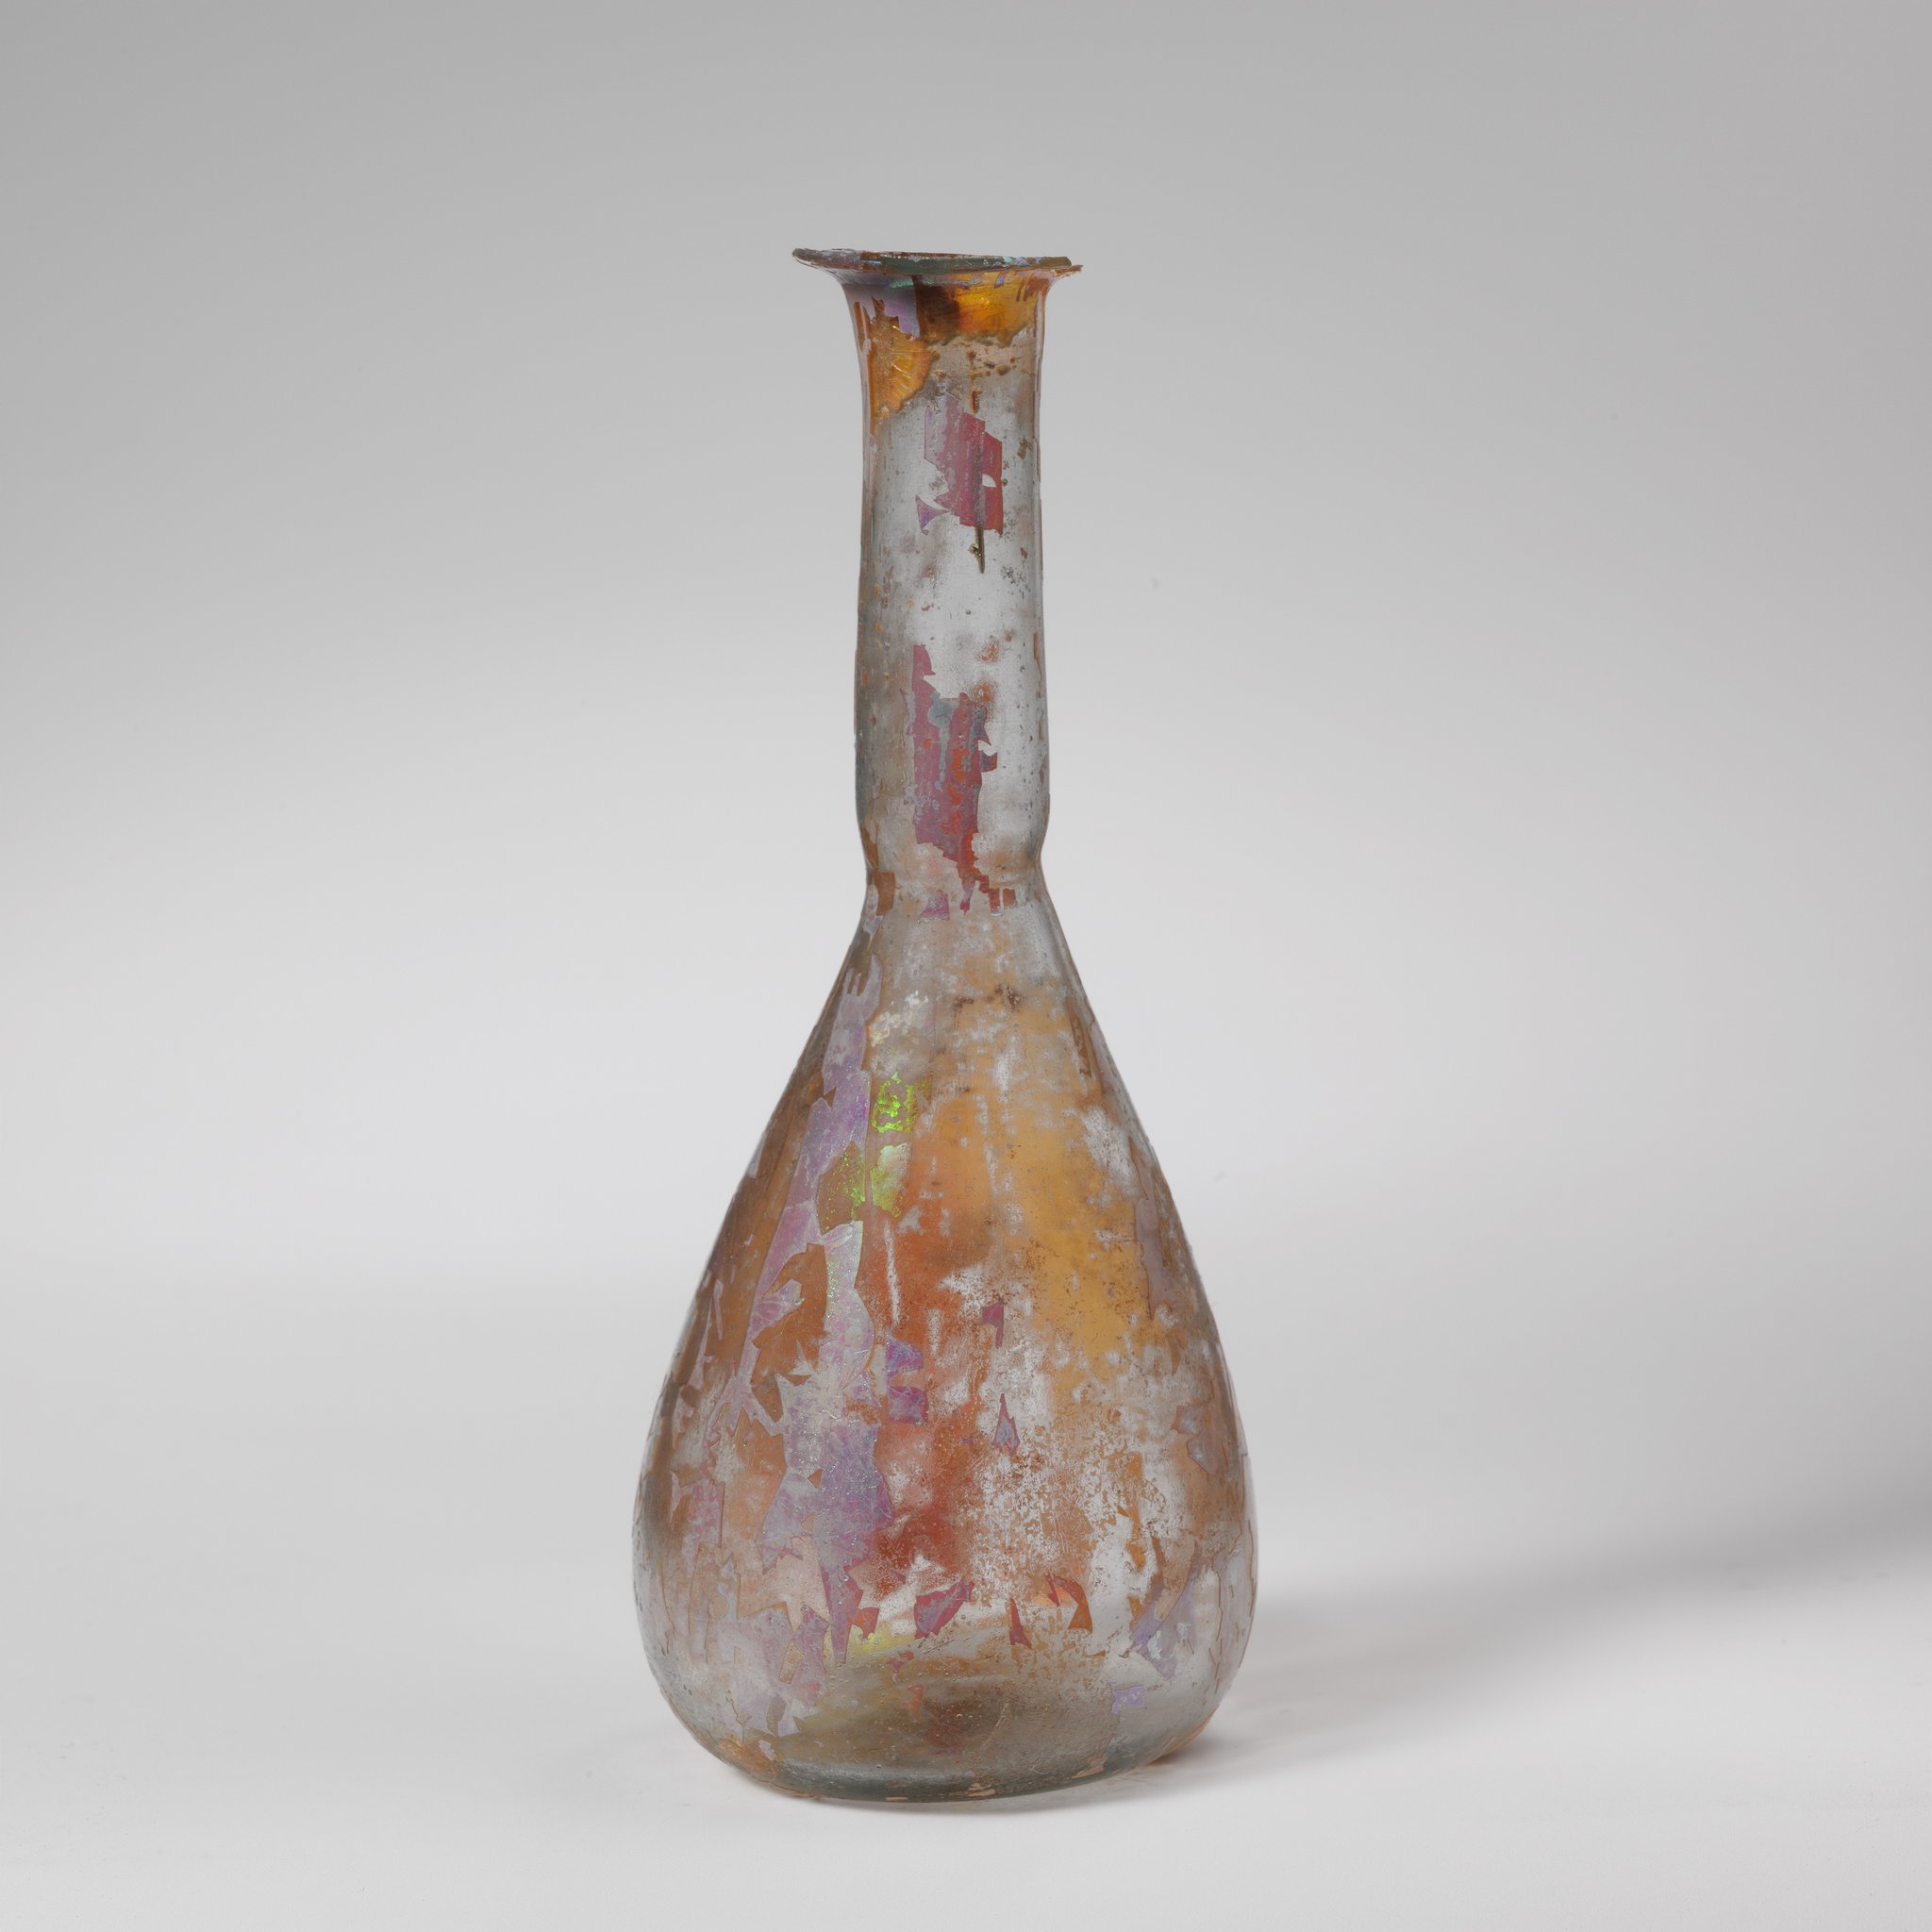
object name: perfume bottle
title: Glass perfume bottle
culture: roman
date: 1-100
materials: glass